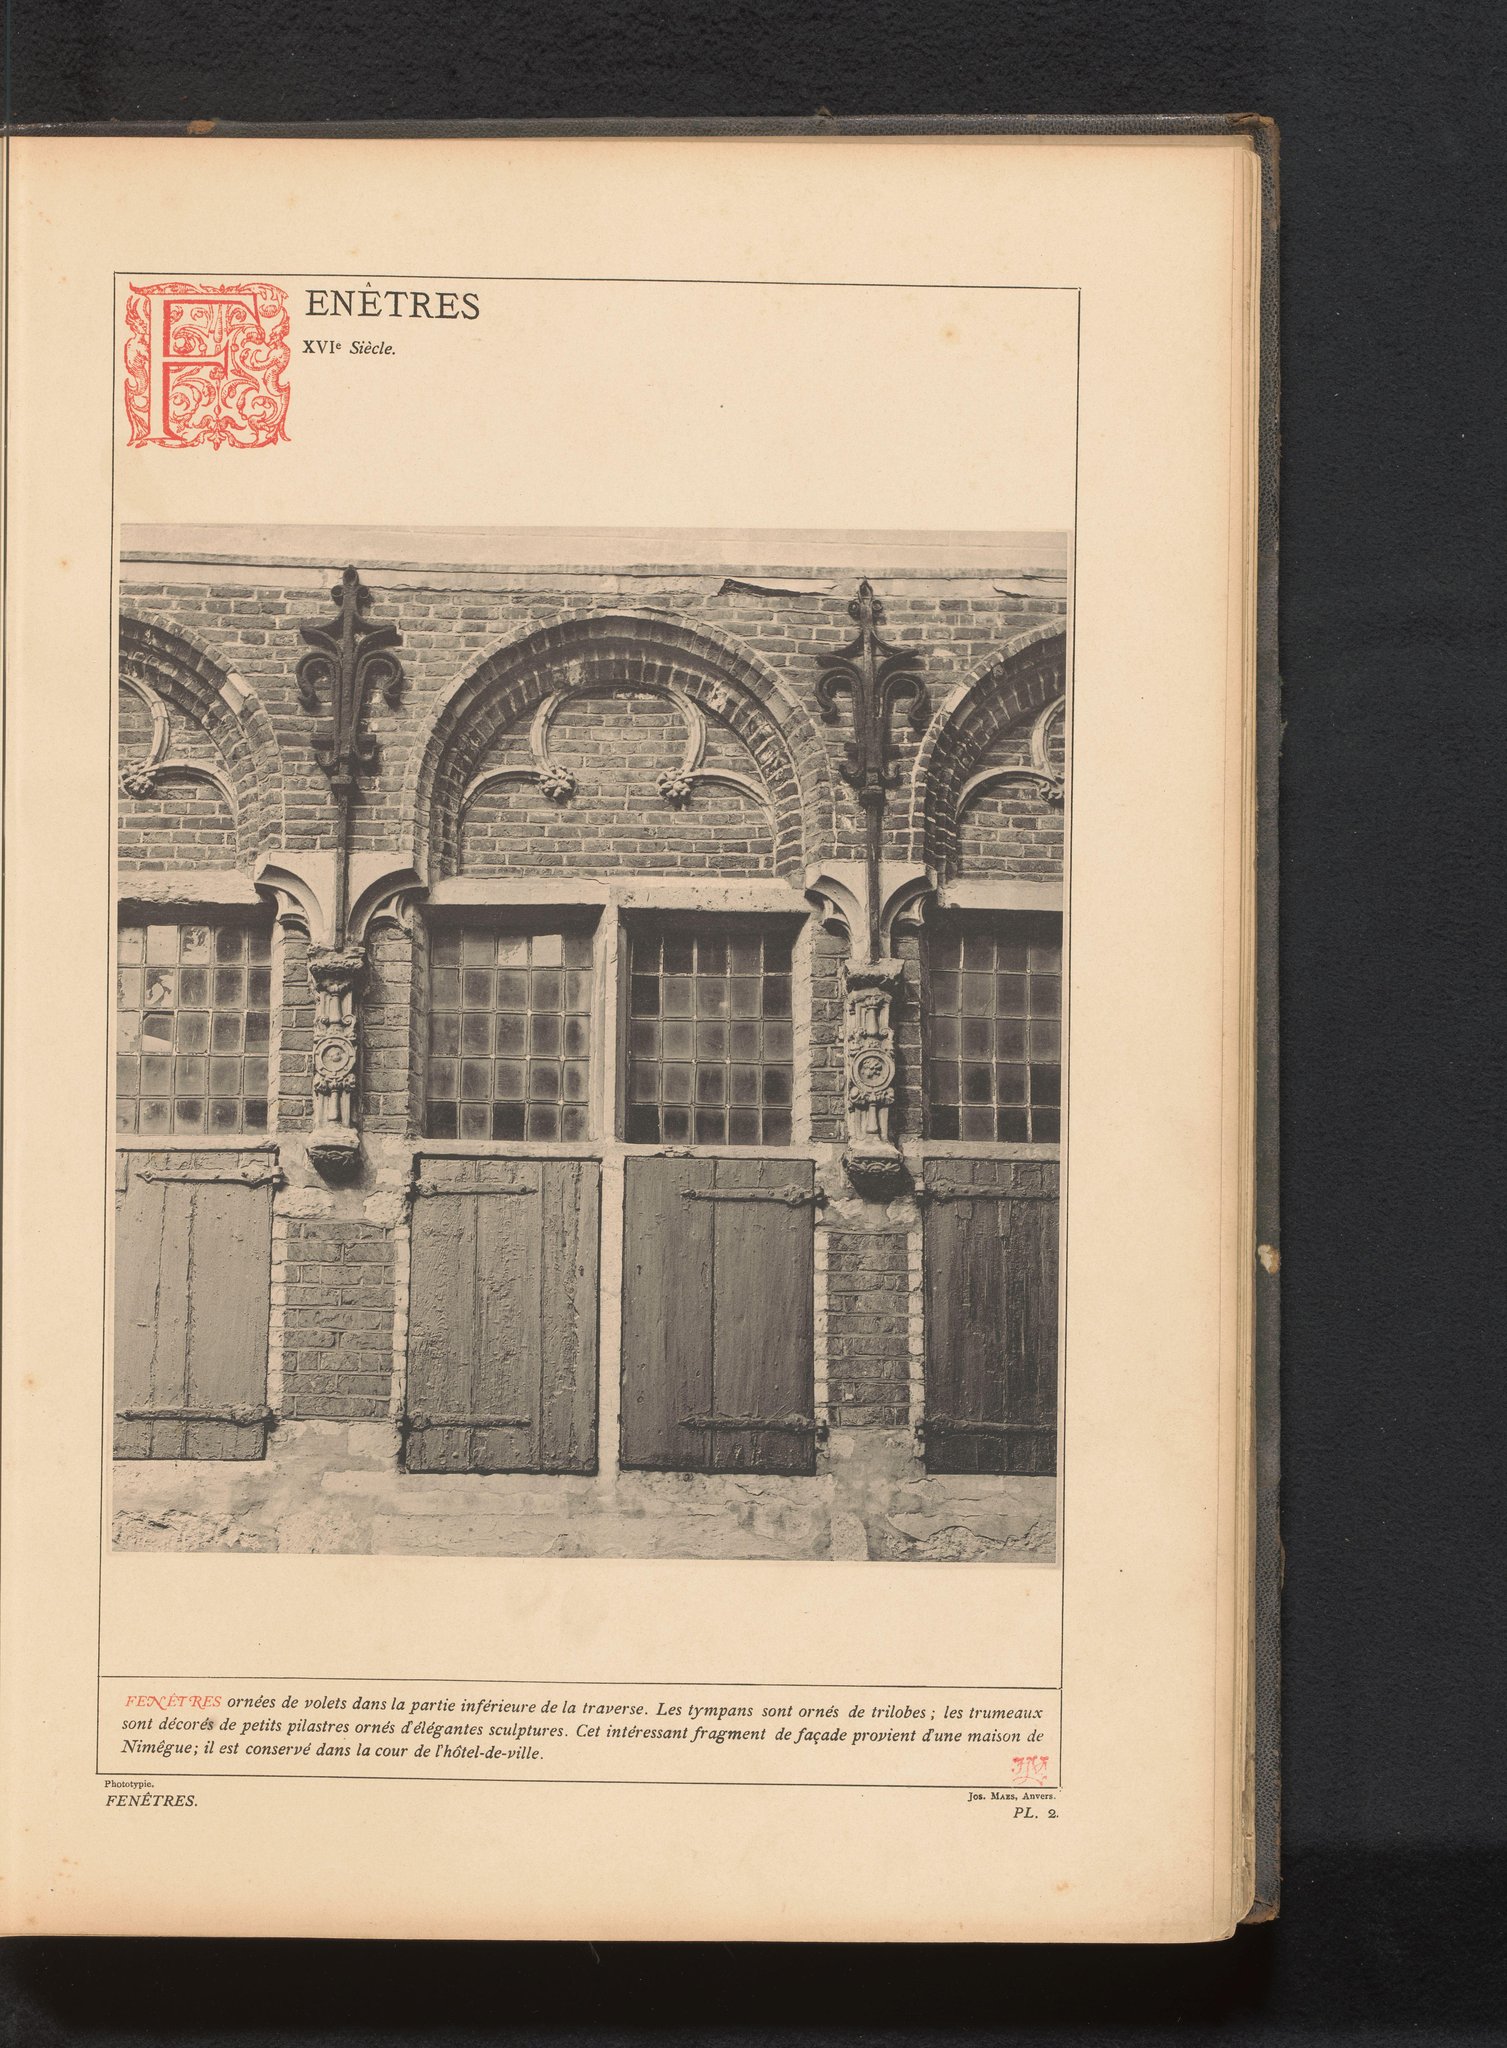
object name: photomechanical print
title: Façade van een huis aan de binnenplaats bij het stadhuis te Nijmegen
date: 1881-1889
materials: paper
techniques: photograph, photolithography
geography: nijmegen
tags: civic architecture; edifices; dwellings, nijmegen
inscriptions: inscription: ‘FENÊTRES. PL. 2.’, inscription: ‘FENÈTRES ornées de (...)’, monogram: ‘JJvY’